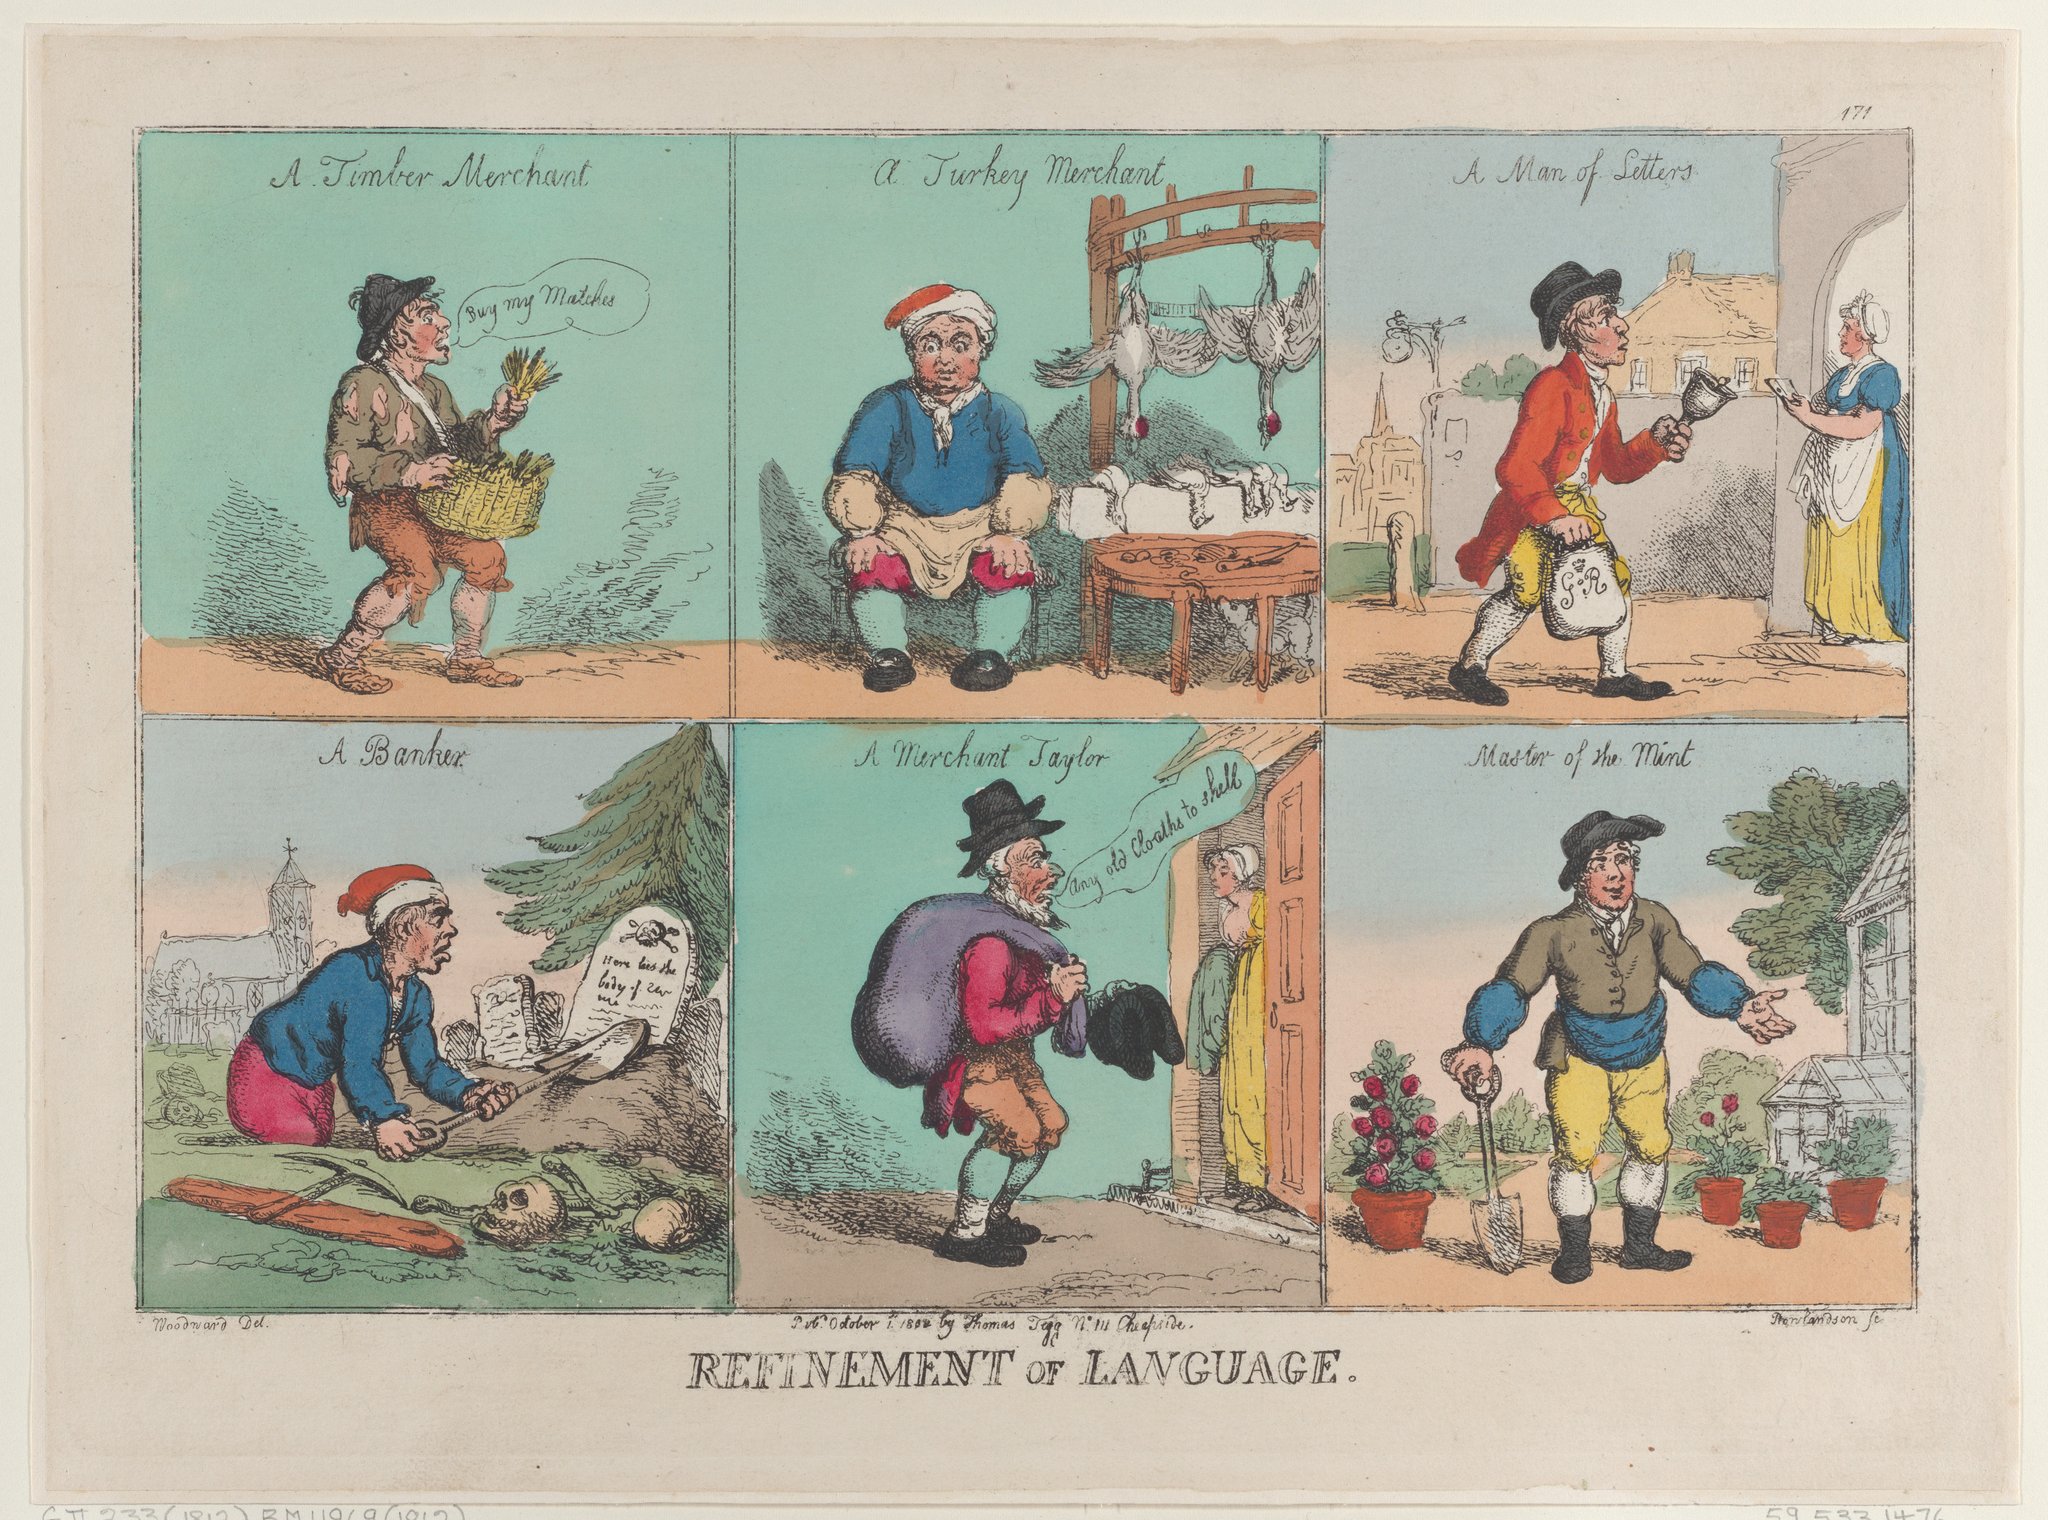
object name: print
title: Refinement of Language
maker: thomas rowlandson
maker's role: artist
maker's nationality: british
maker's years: 1757-1827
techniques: etching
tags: satire,men